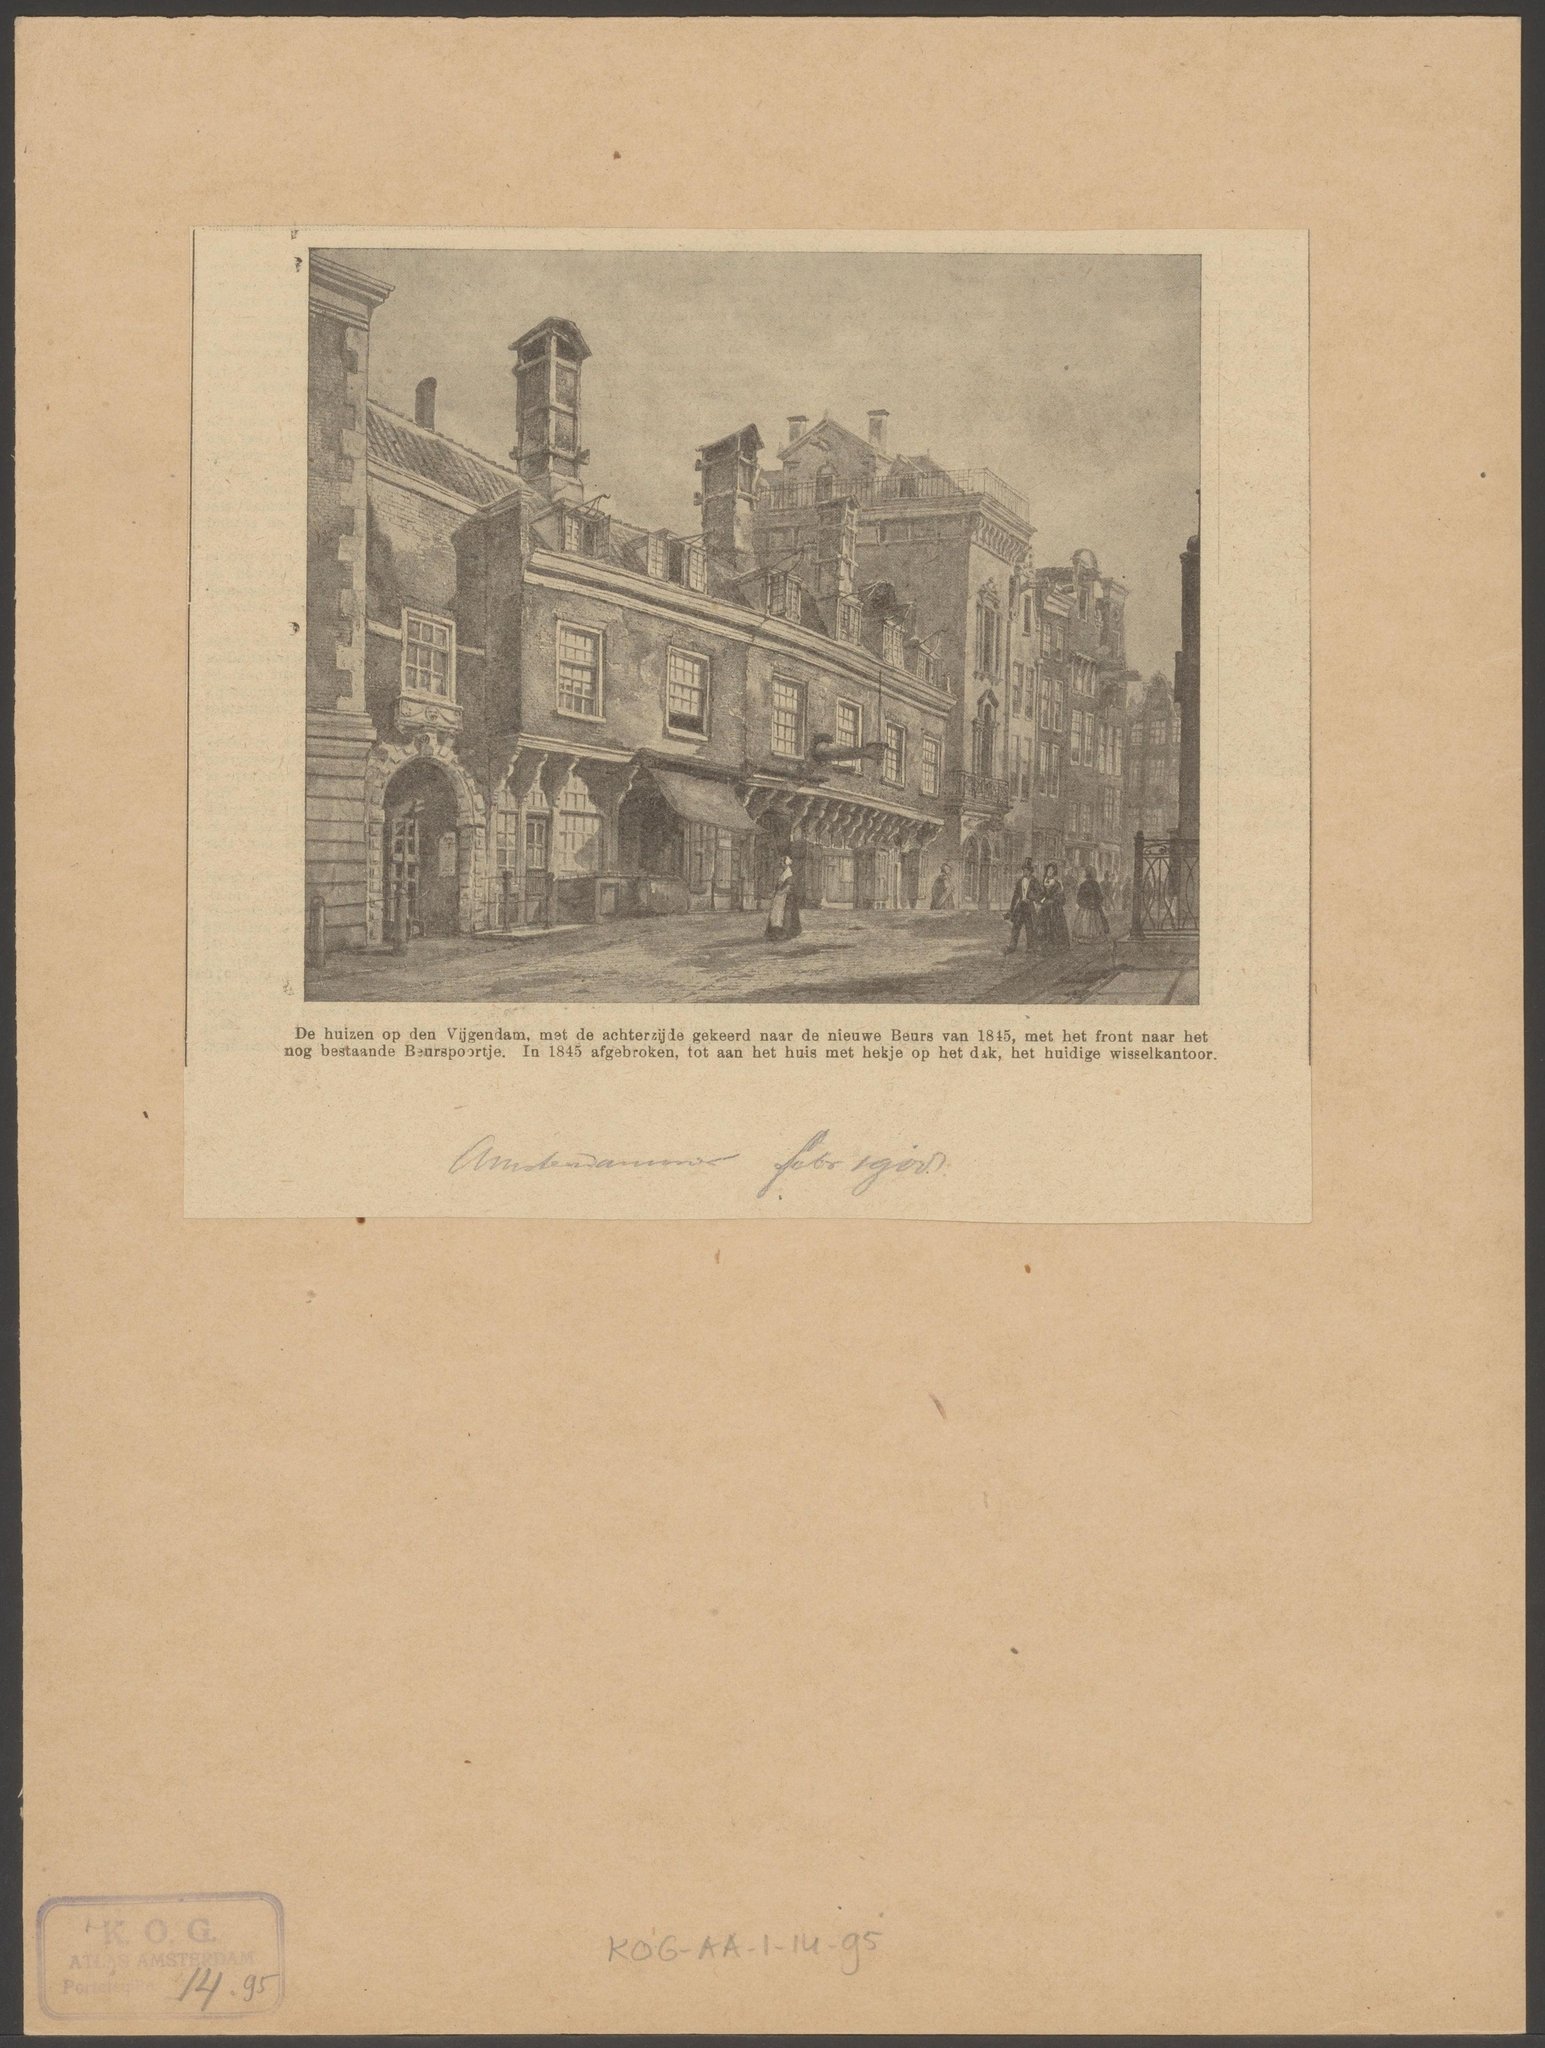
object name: photomechanical print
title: Gezicht op de Vijgendam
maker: Anonymous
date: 1902-1908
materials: paper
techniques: letterpress printing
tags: city-view in general; 'veduta', façade (of house or building), street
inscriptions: collector's mark: ‘14.95’ Lugt 1641b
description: Onderwerpsrubriek binnen de Atlas Amsterdam: Voorburgwal (O.Z.), Voorweg, Vijgendam, Vijzelstraat.